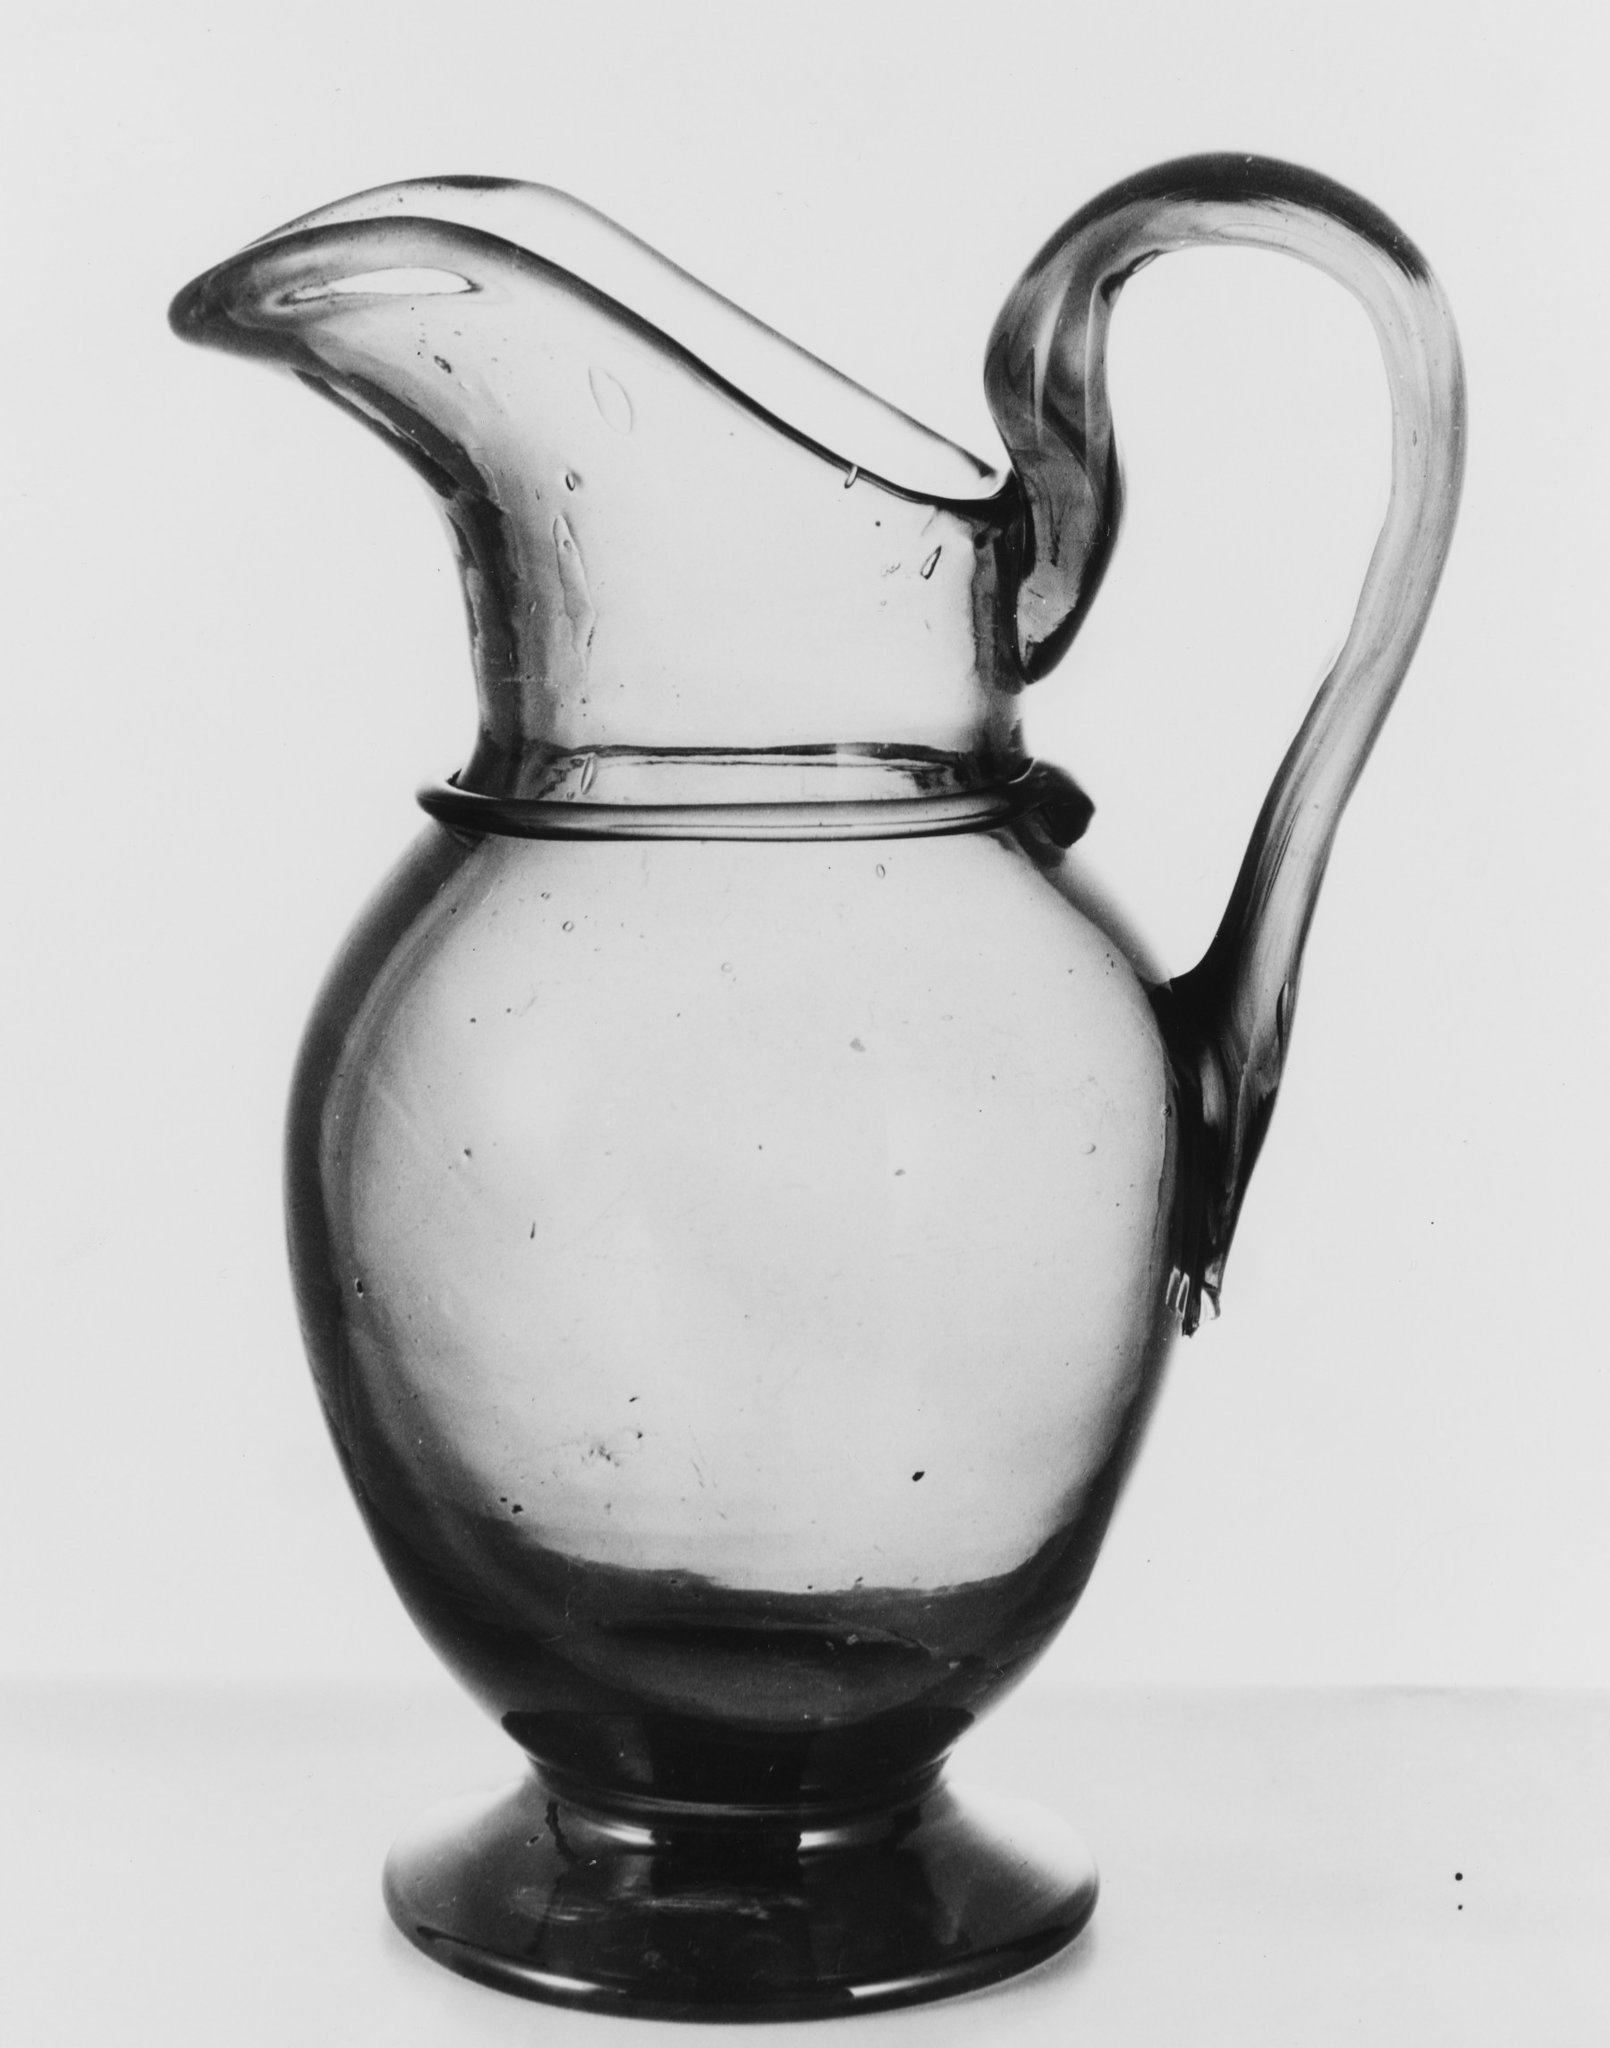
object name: pitcher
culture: american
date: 1800-1830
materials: glass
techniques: glassblowing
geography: united states